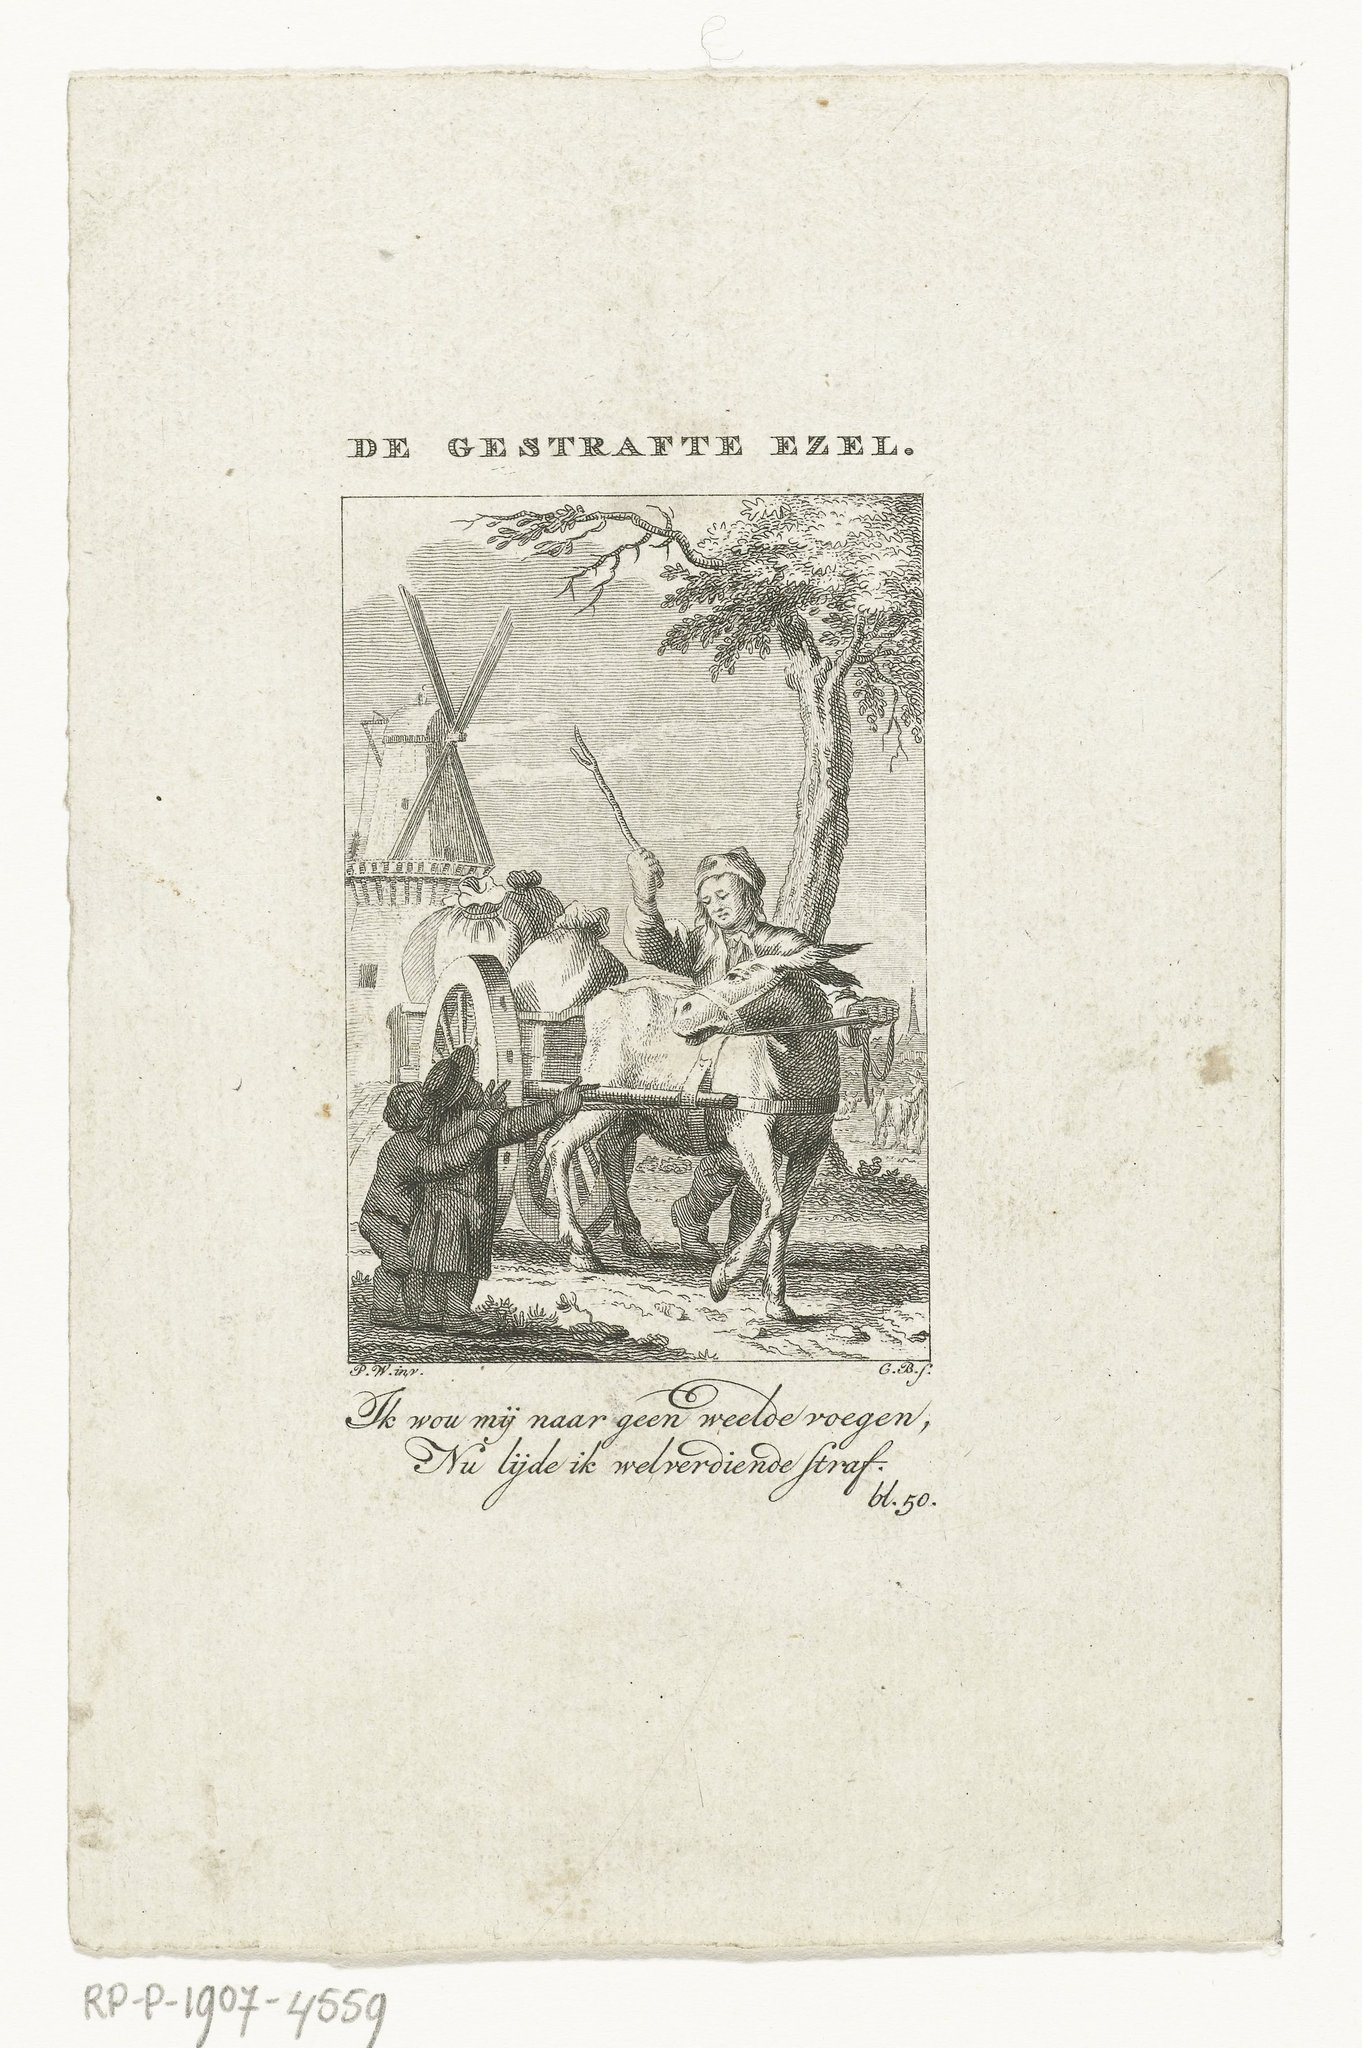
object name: print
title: De gestrafte ezel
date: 1778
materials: paper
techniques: etching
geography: netherlands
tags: ass, donkey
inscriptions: collector's mark: Lugt 2228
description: Man drijft een ezel met kar, juist vertrokken bij de molen en volgeladen met zakken meel. De ezel draait gekweld zijn kop naar achteren terwijl twee kinderen spottend naar het dier wijzen. Volgens het begeleidende vers in de uitgave en de twee geciteerde versregels onder de voorstelling wordt de ezel gestraft met hard werken omdat hij klaagt over zijn leven.